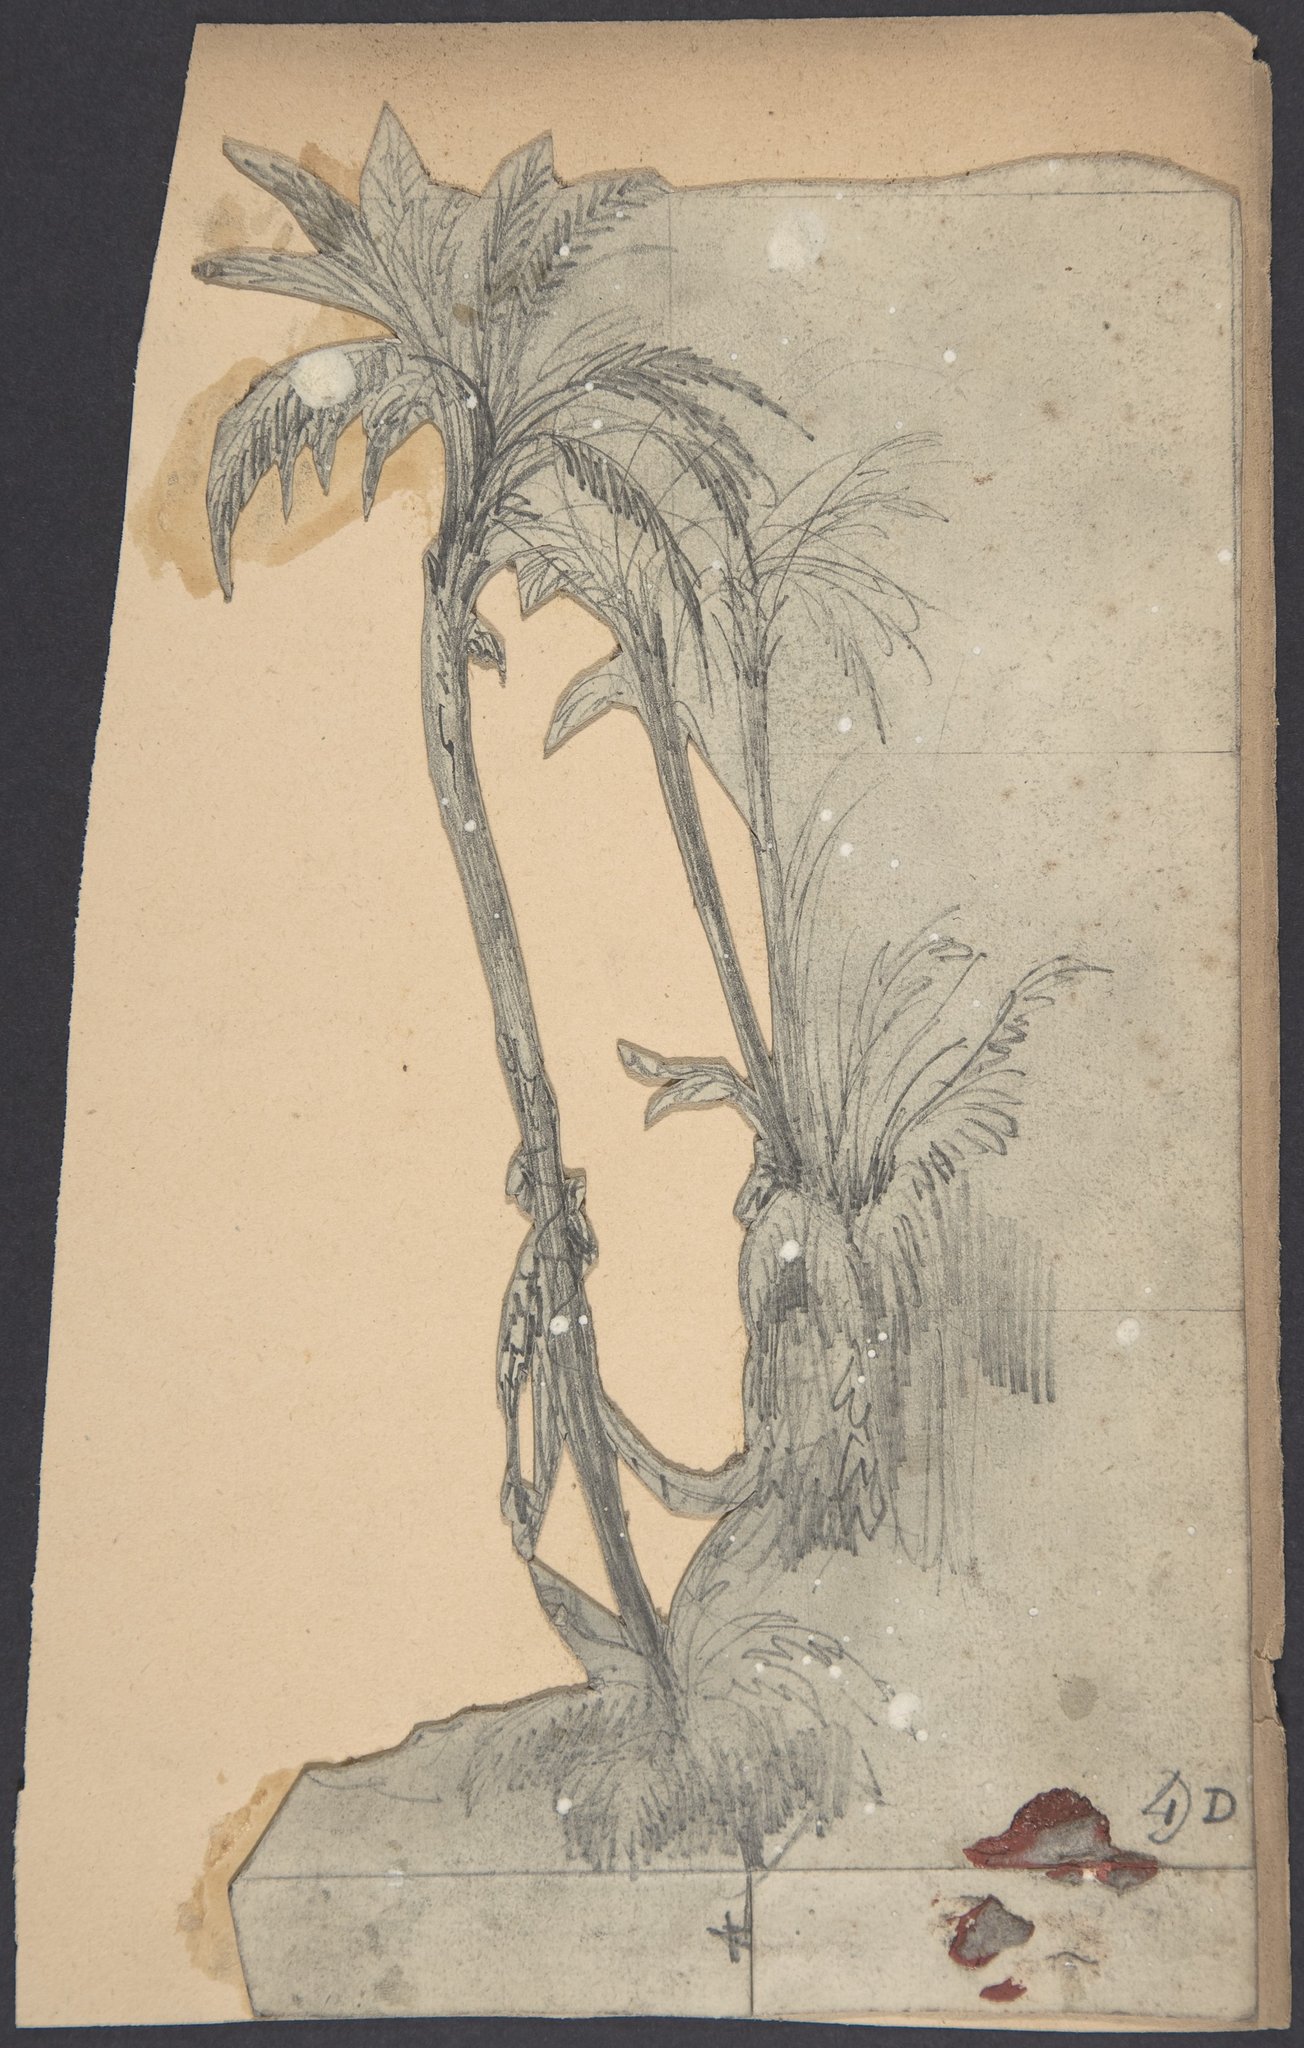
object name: drawing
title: Design for a Stage Set at the Opéra, Paris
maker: eugène cicéri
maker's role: artist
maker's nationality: french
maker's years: 1813-1890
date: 1830-1890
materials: graphite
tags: trees,stage design